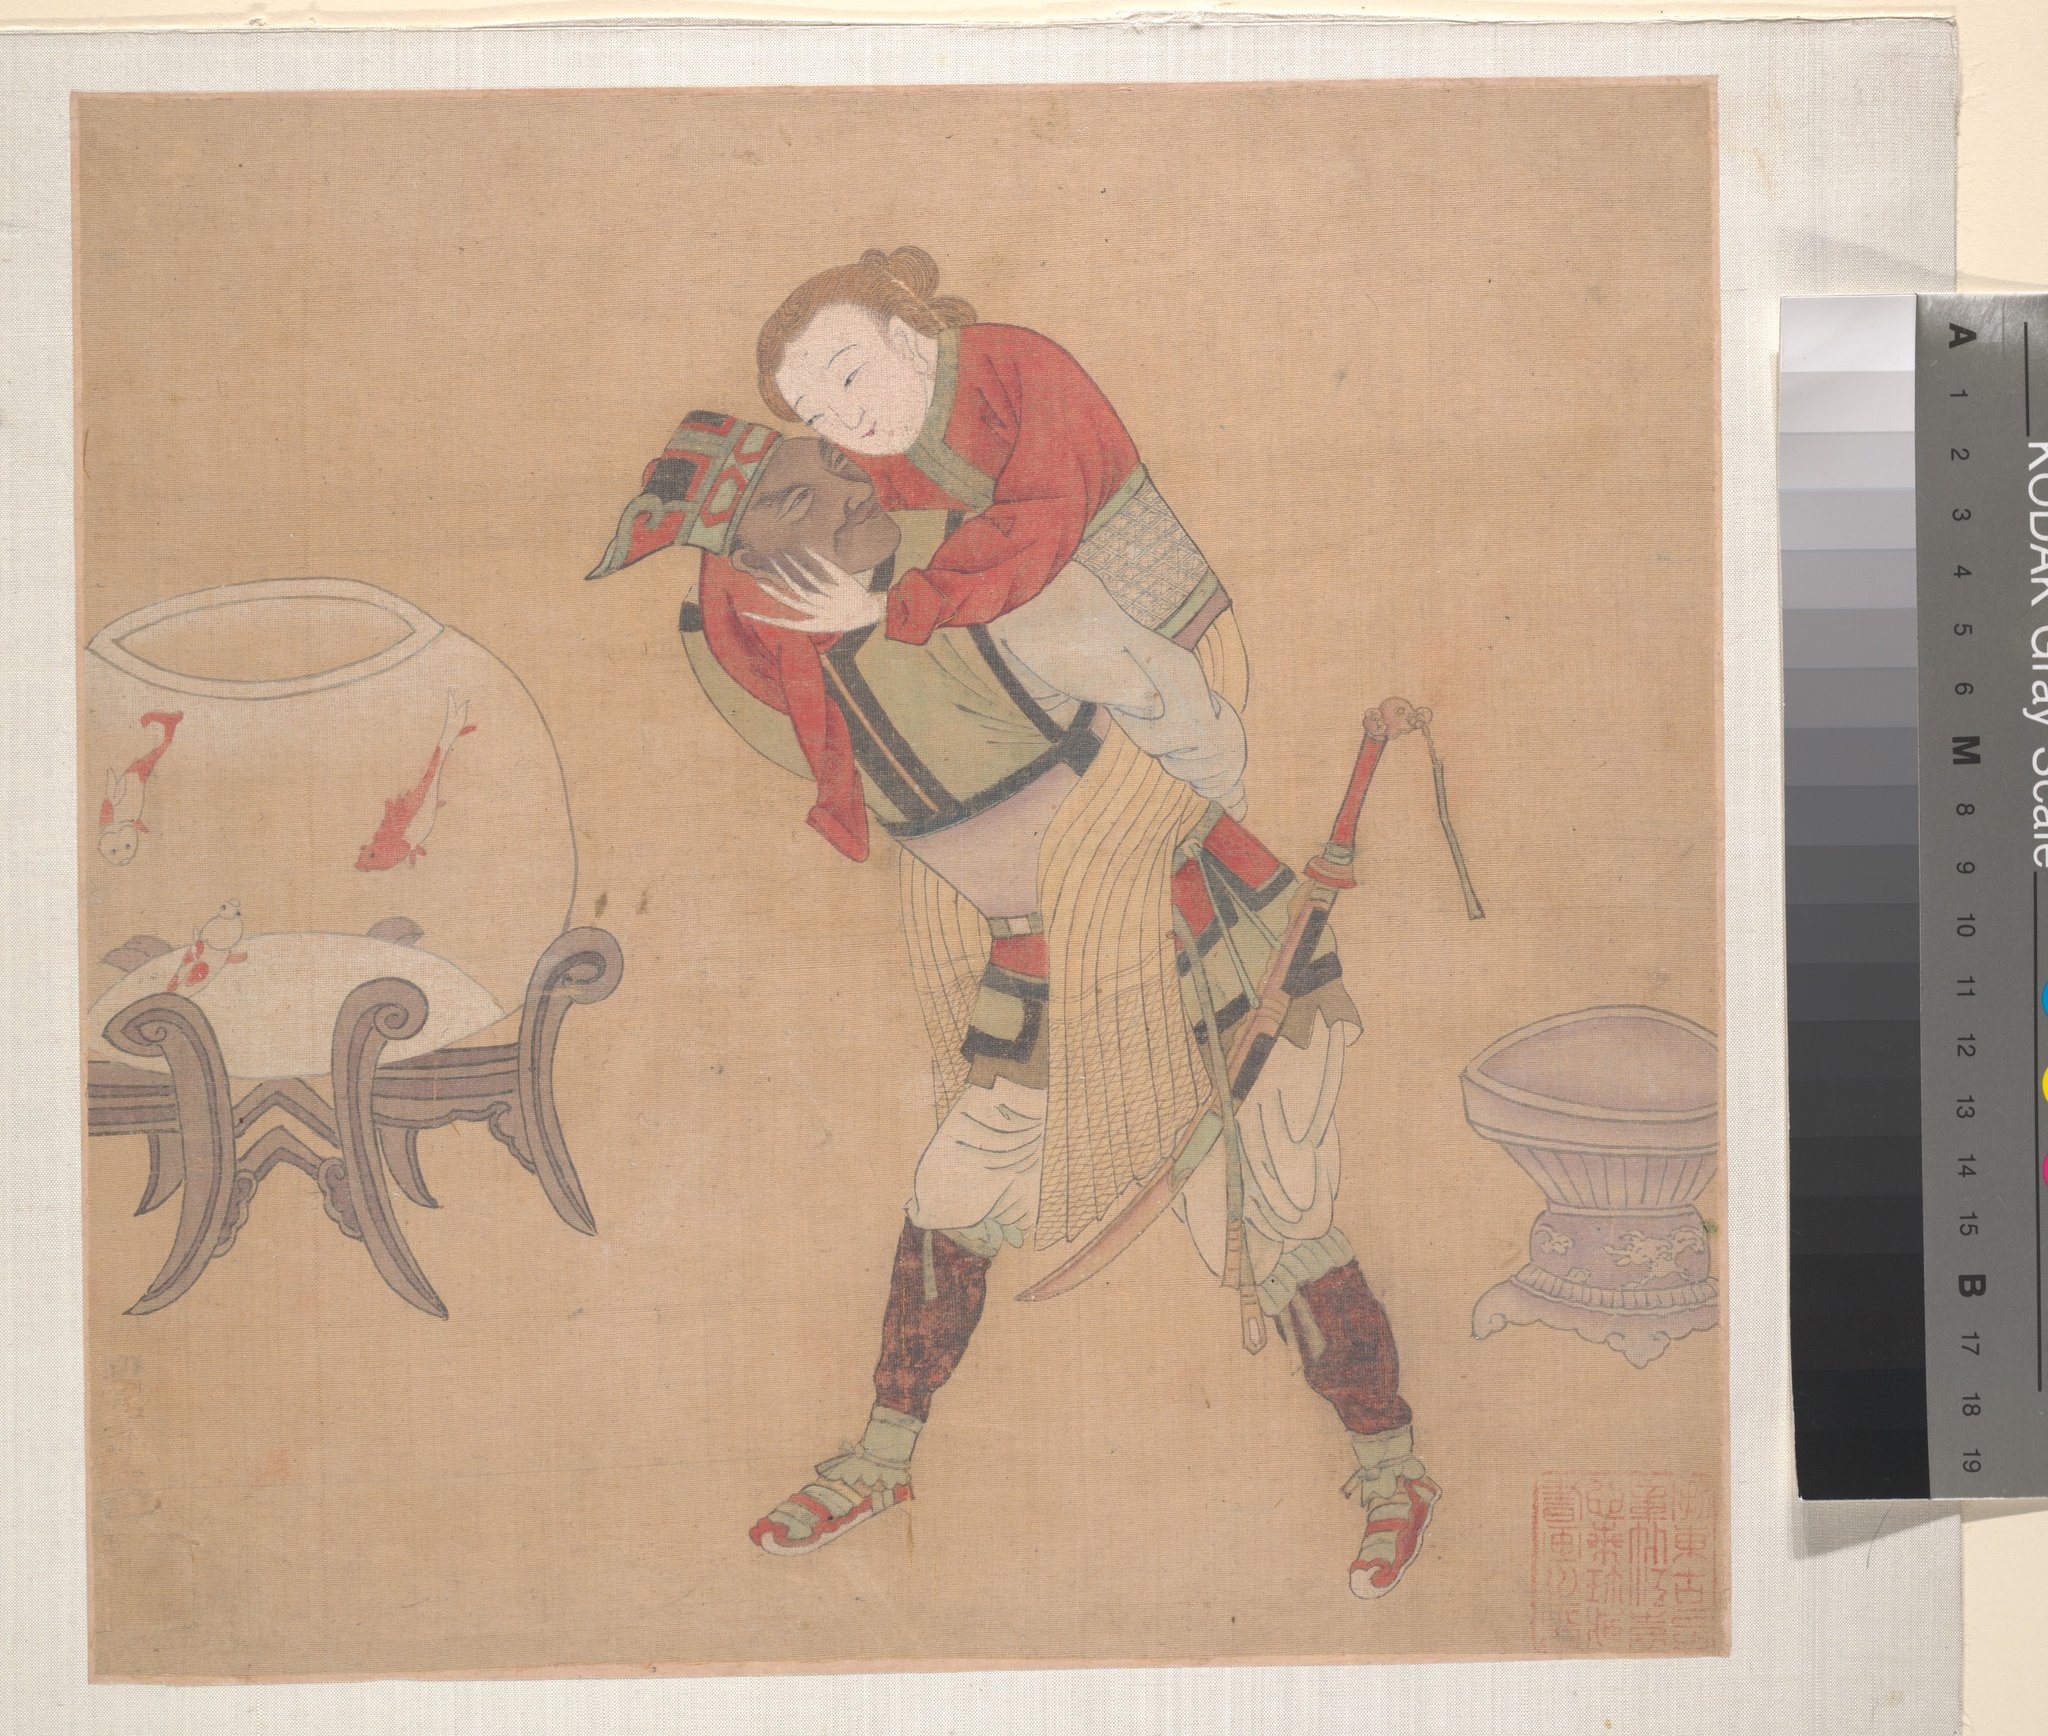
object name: album leaf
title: Tartar Officer Carrying Blond Lady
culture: chinese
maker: unidentified artist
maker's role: artist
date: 1801-1900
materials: ink, silk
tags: men,women,fish